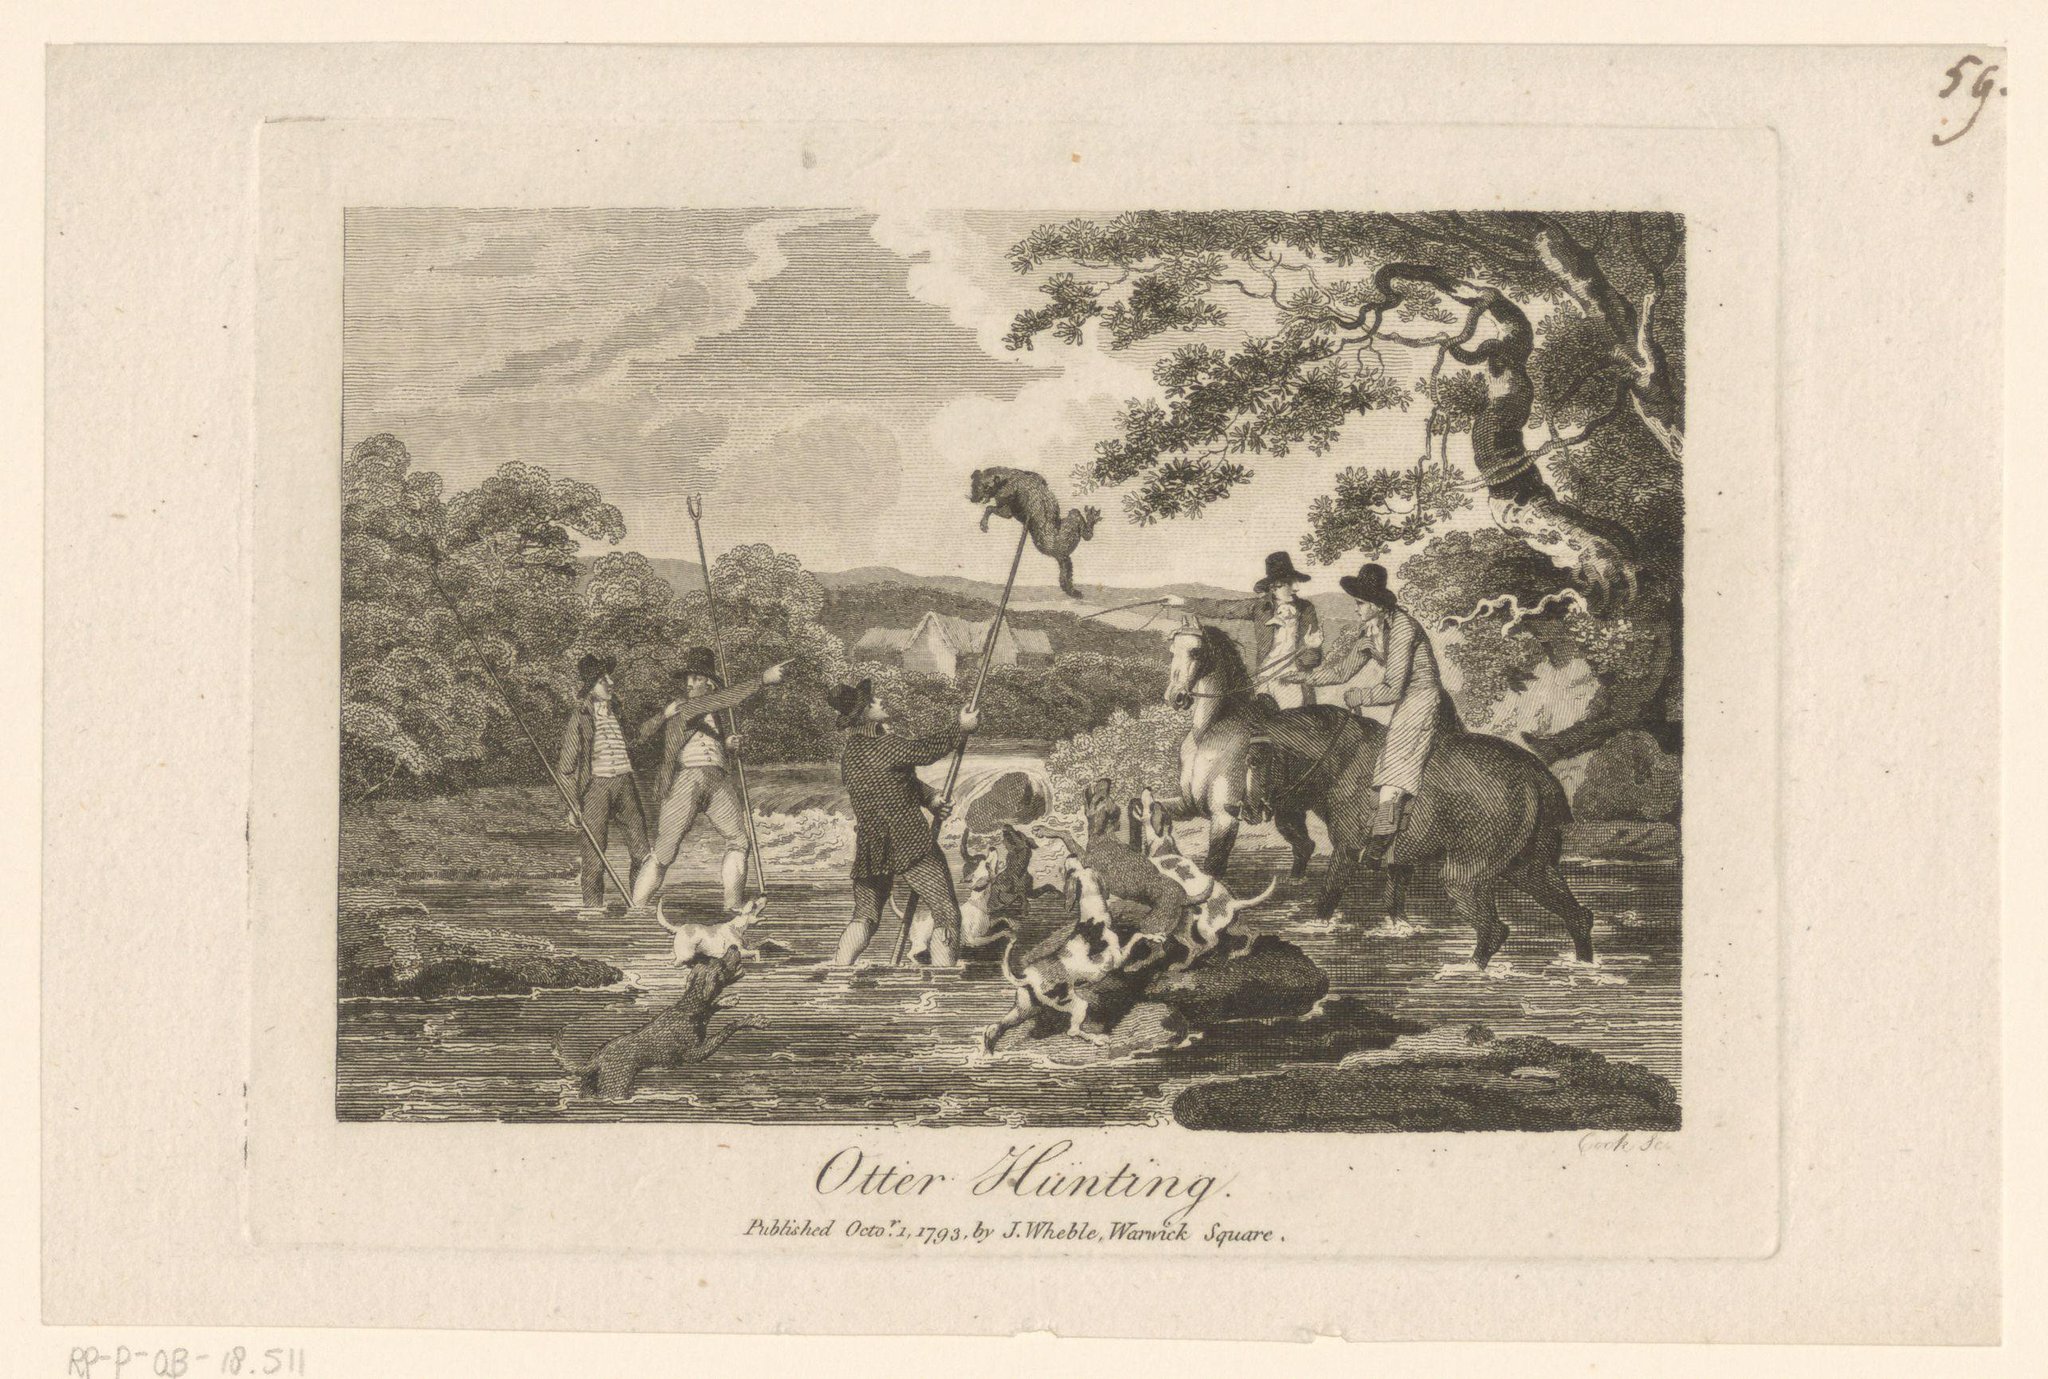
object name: print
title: Mannen jagen op otters in een rivier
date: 1793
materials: paper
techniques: etching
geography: london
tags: hunt ~ mammals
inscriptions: number: ‘59’, collector's mark: Lugt 2228